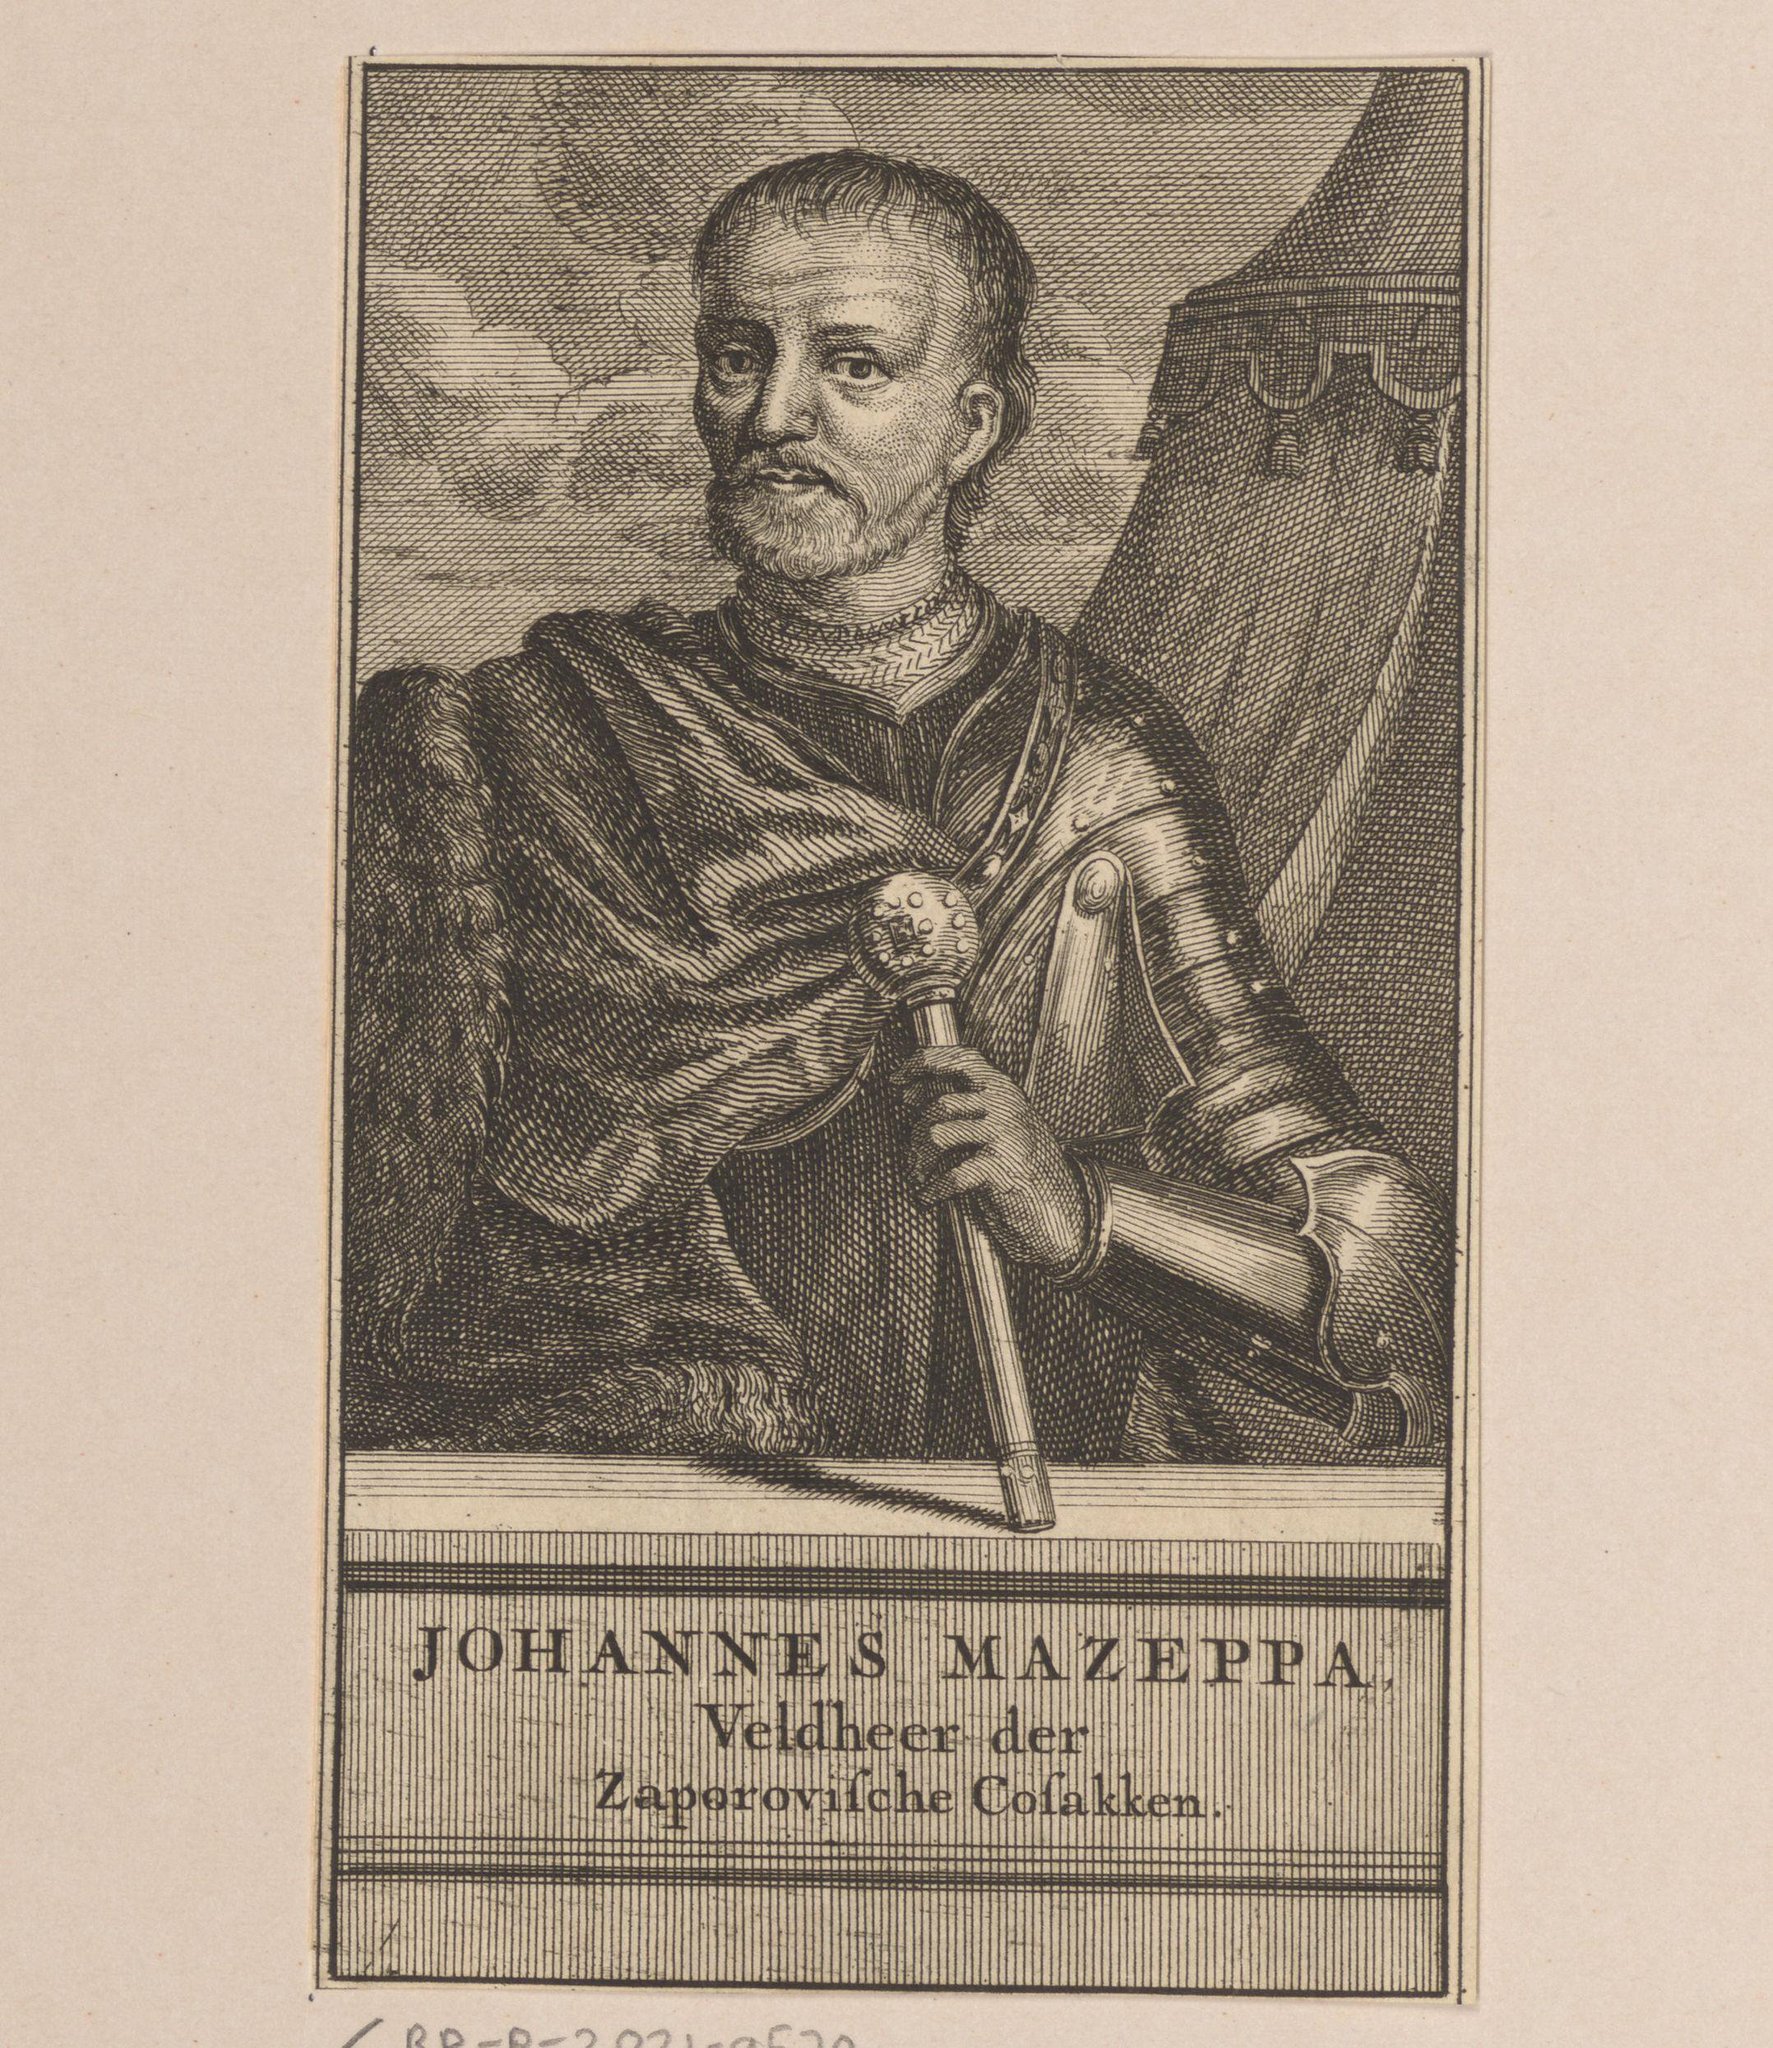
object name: print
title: Johannes Mazeppa, Veldheer der Zaporovische Cosakken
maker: Anonymous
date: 1690-1750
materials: paper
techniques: etching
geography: northern netherlands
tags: (military) camp with tents, commander-in-chief, general, marshal, armour, historical persons